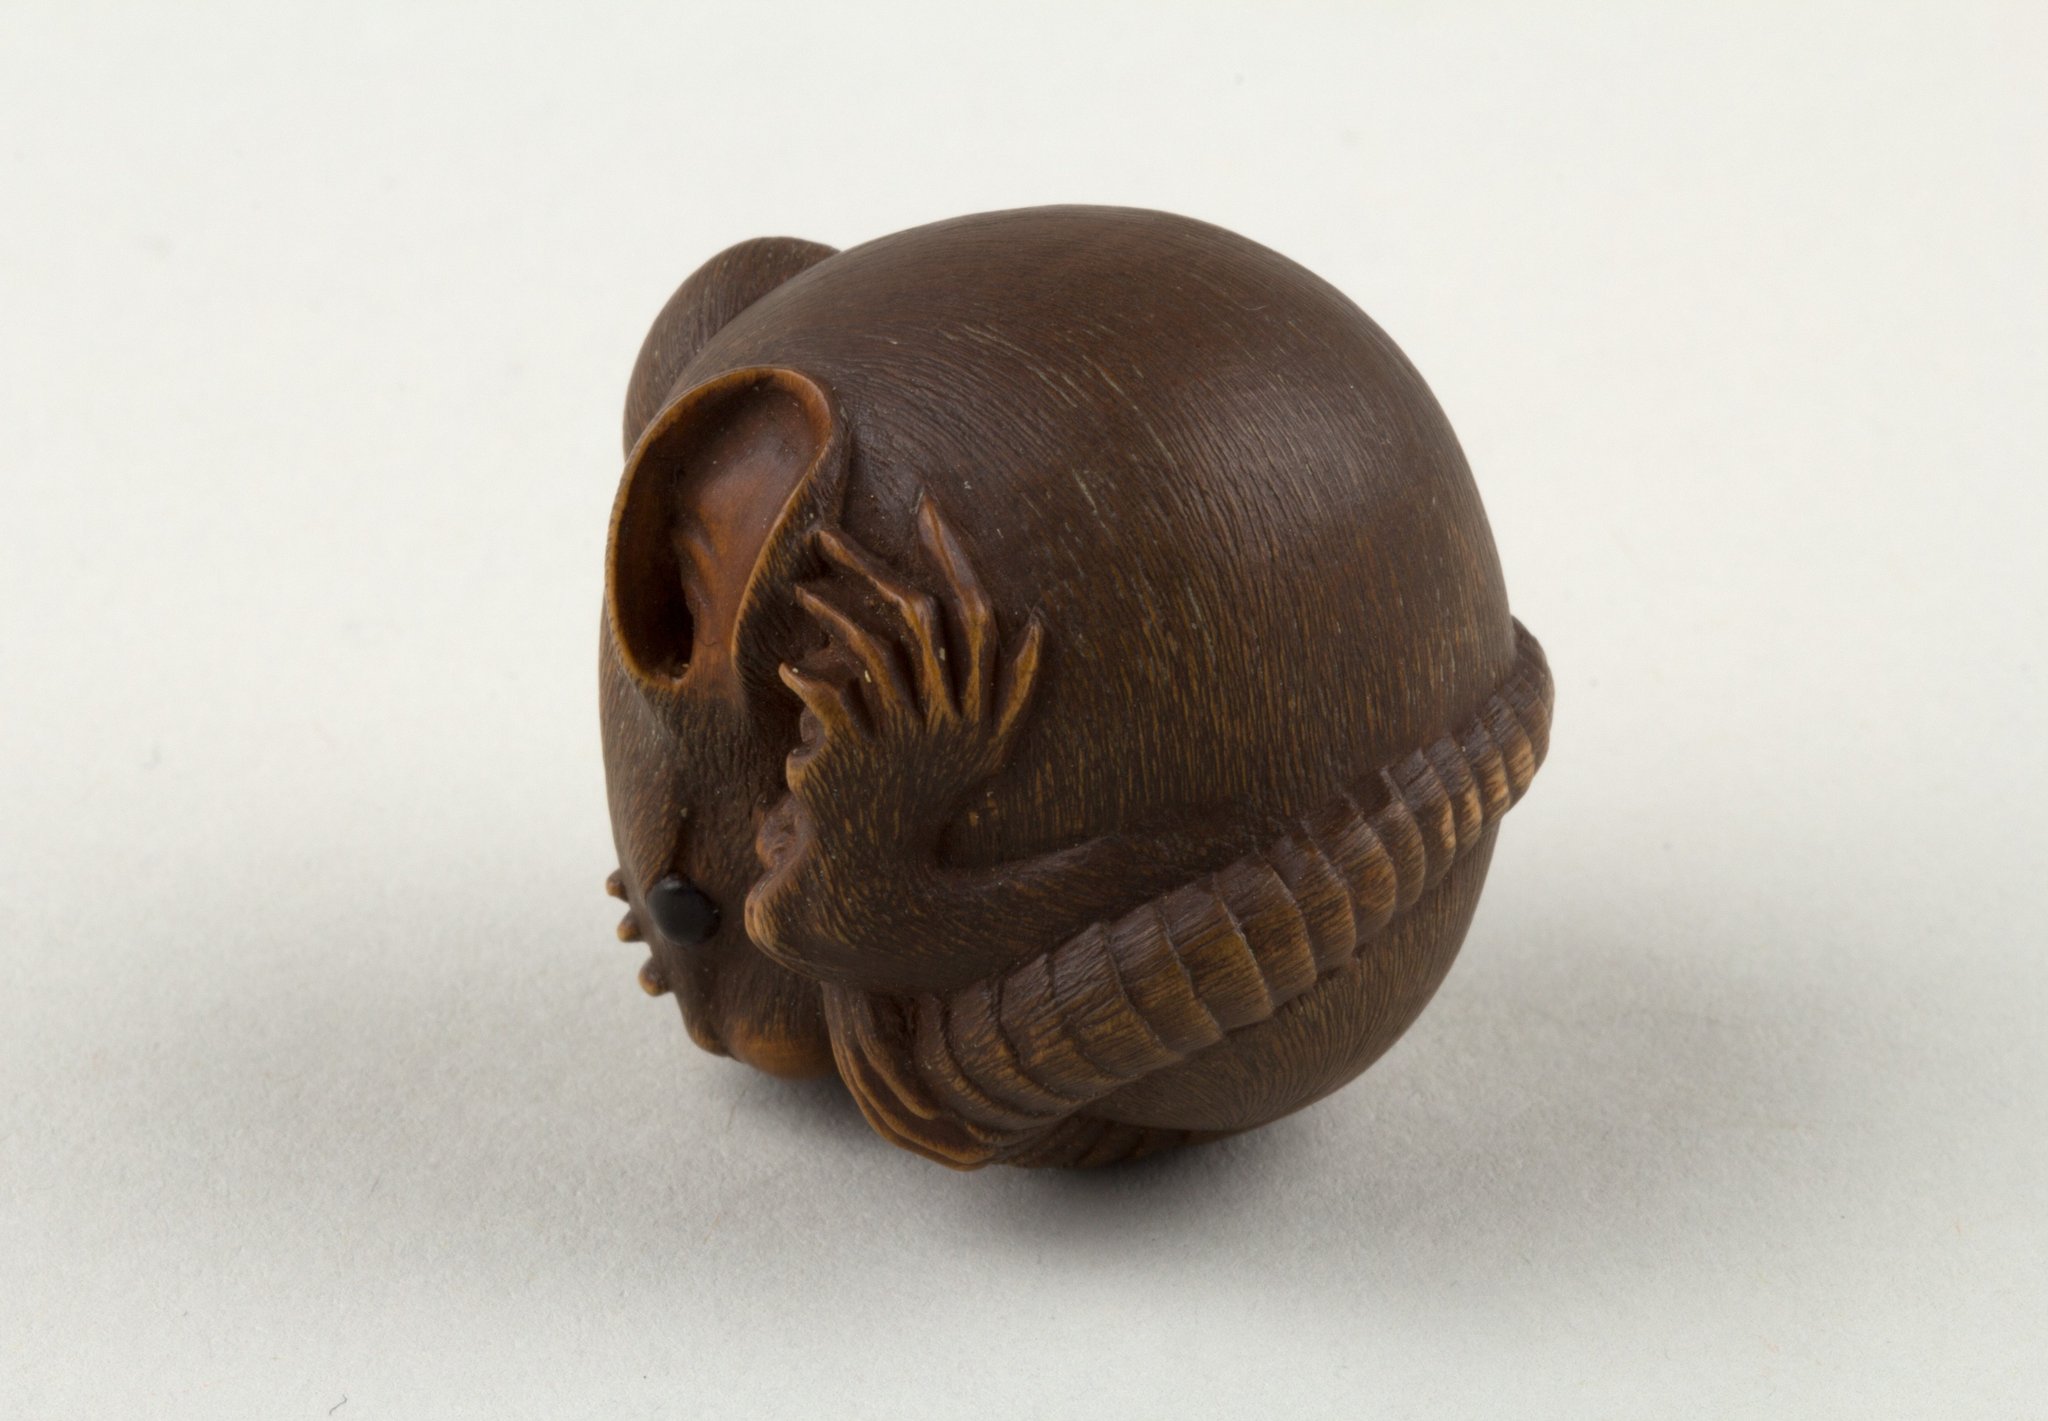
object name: netsuke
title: Netsuke of a Rat Curled into a Ball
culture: japanese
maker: masanao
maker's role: artist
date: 1801-1900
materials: wood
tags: rats